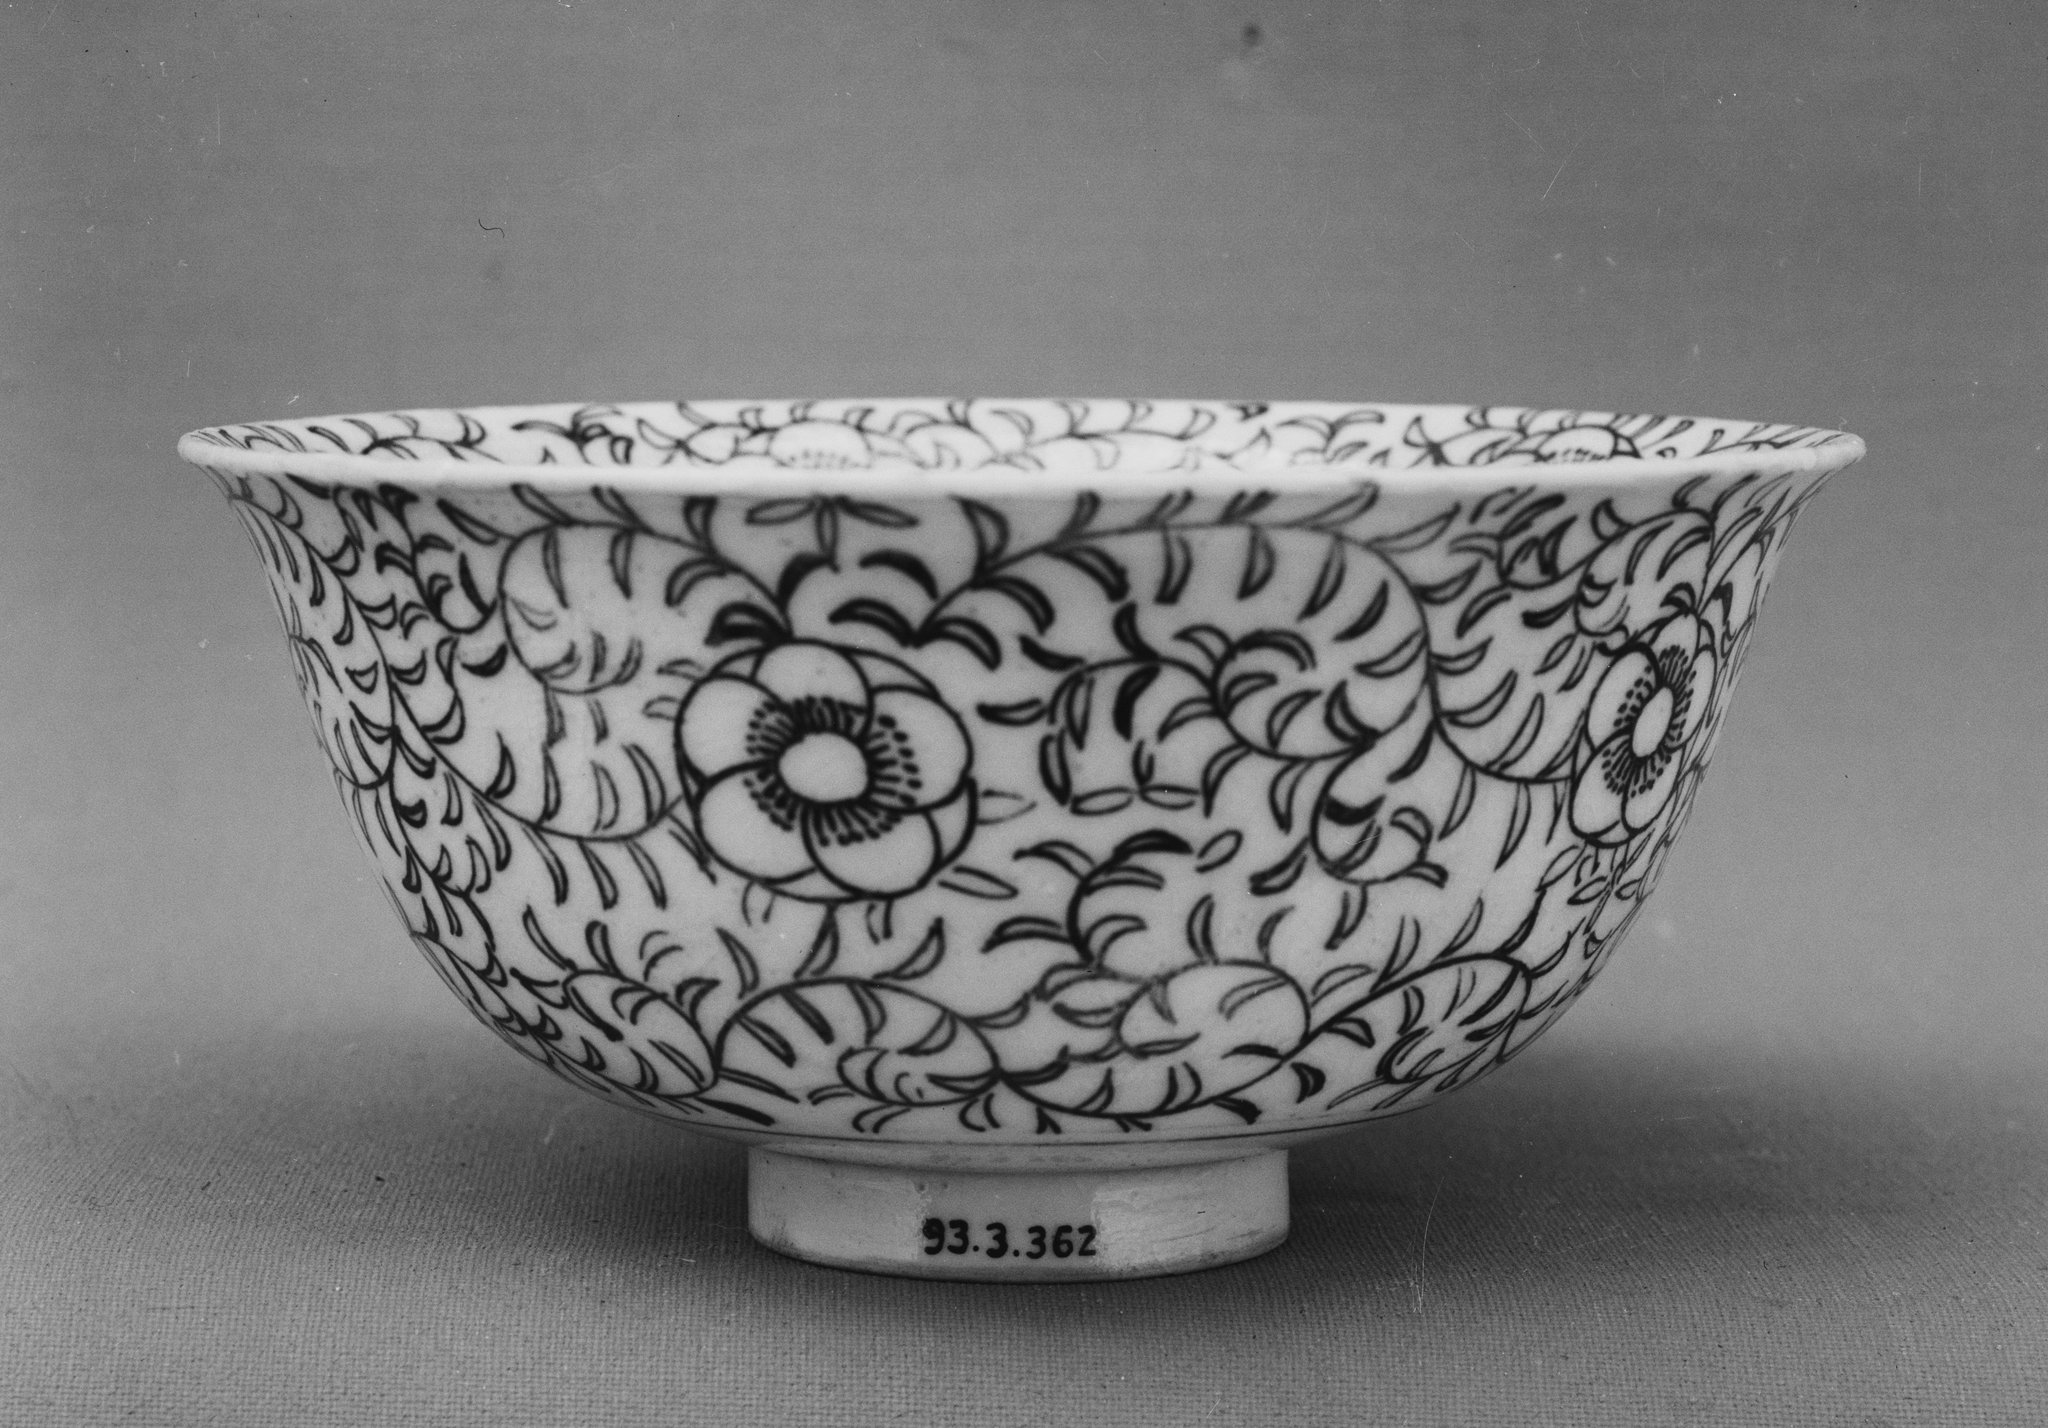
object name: cup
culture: japanese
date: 1840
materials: glaze